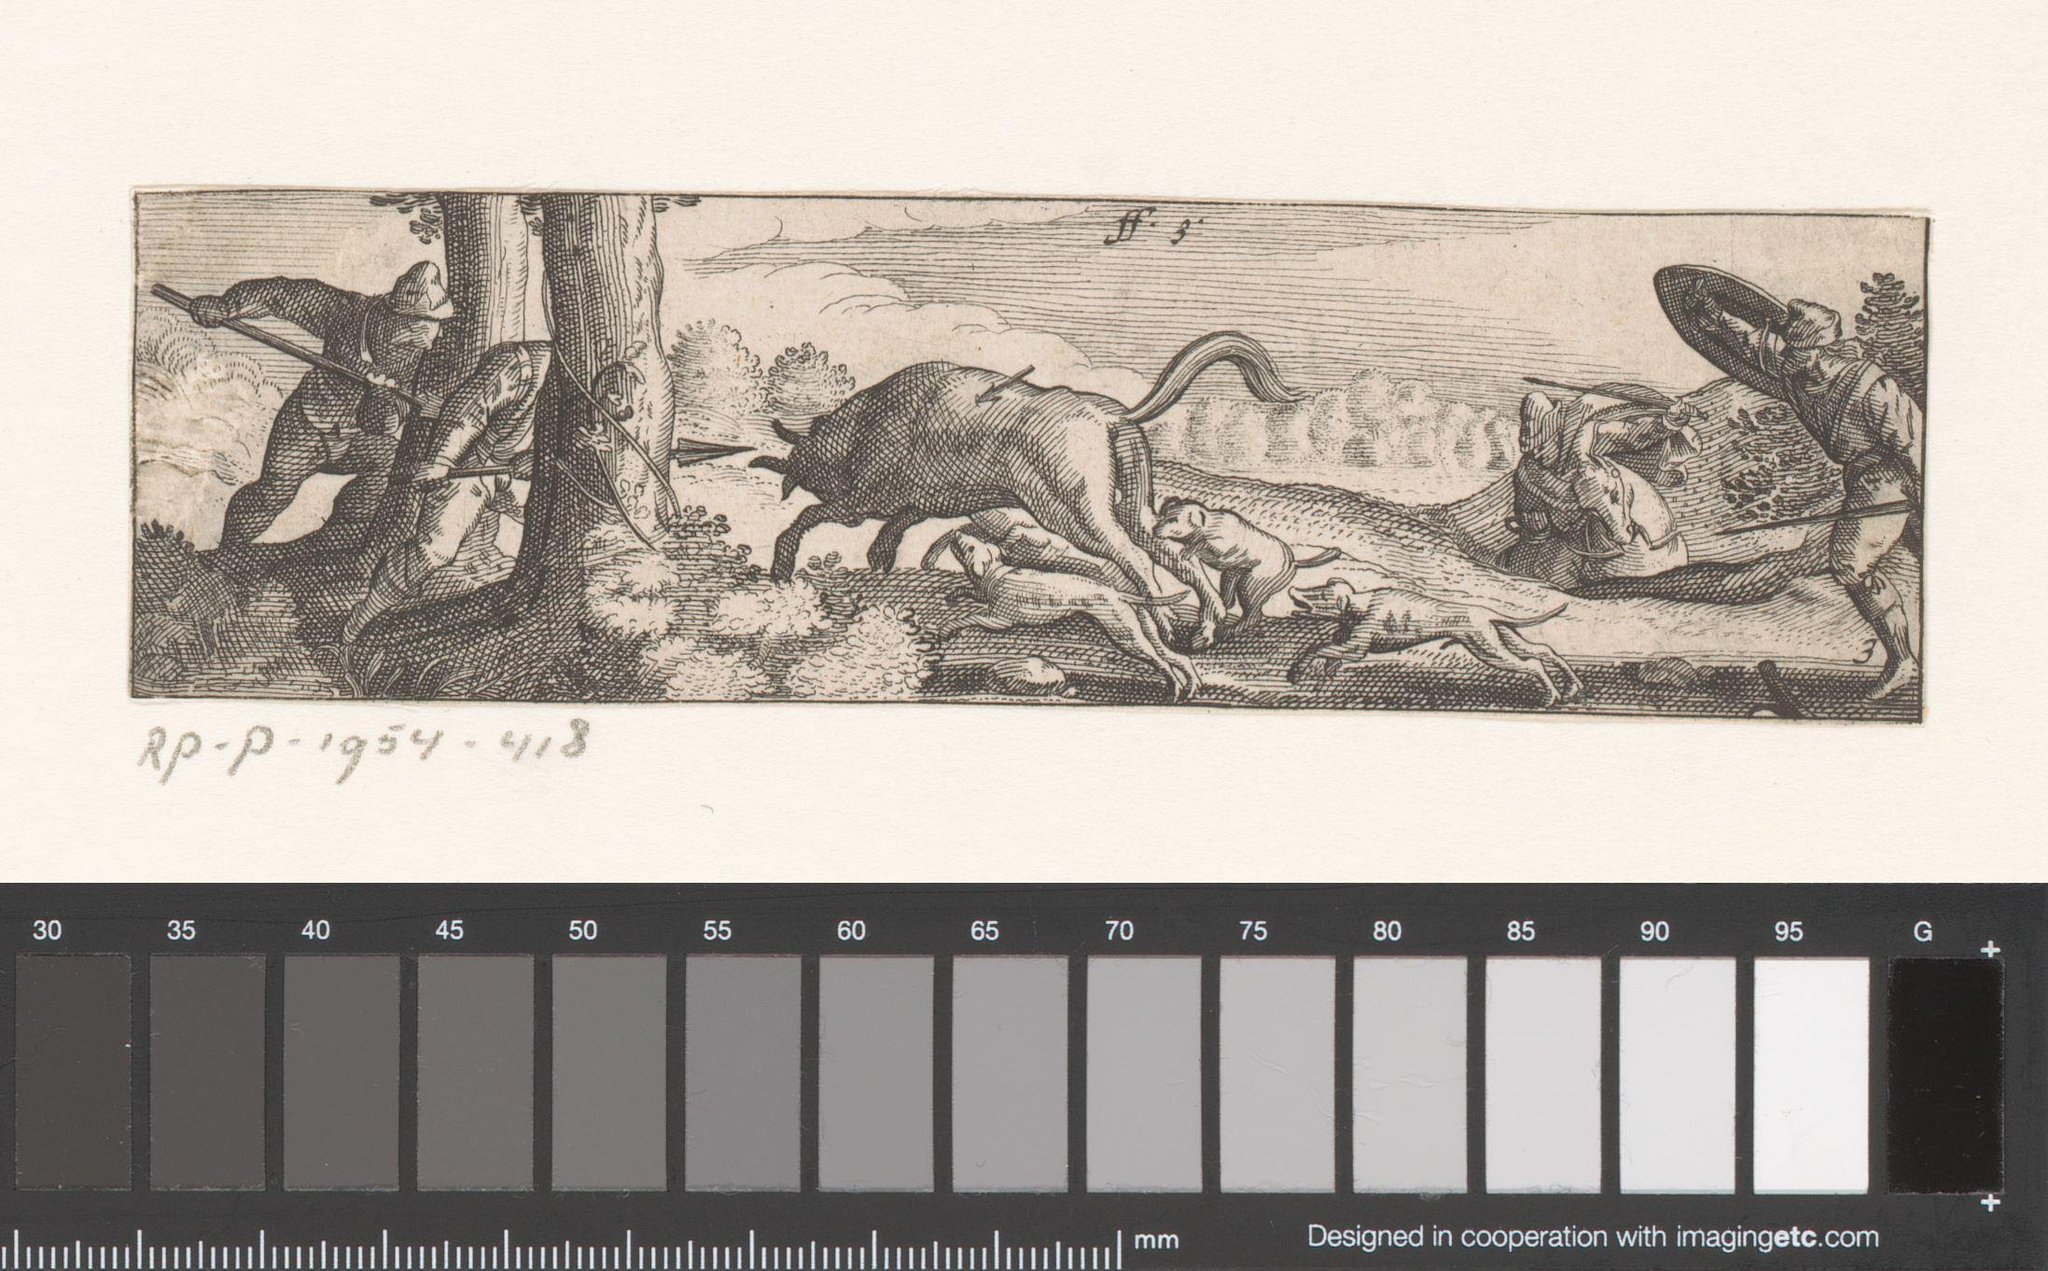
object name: print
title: Stierenjacht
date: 1596-1652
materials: paper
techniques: etching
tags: protective weapons: shield, bull, hunting dogs, helved weapons, polearms (for striking, hacking, thrusting), hunt ~ hoofed animals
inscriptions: collector's mark: Lugt 2228, number: ‘ff.3.’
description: Kopie in spiegelbeeld naar een prent van Hans Bol, uitgegeven door Philip Galle (Hollstein Dutch VII 570).